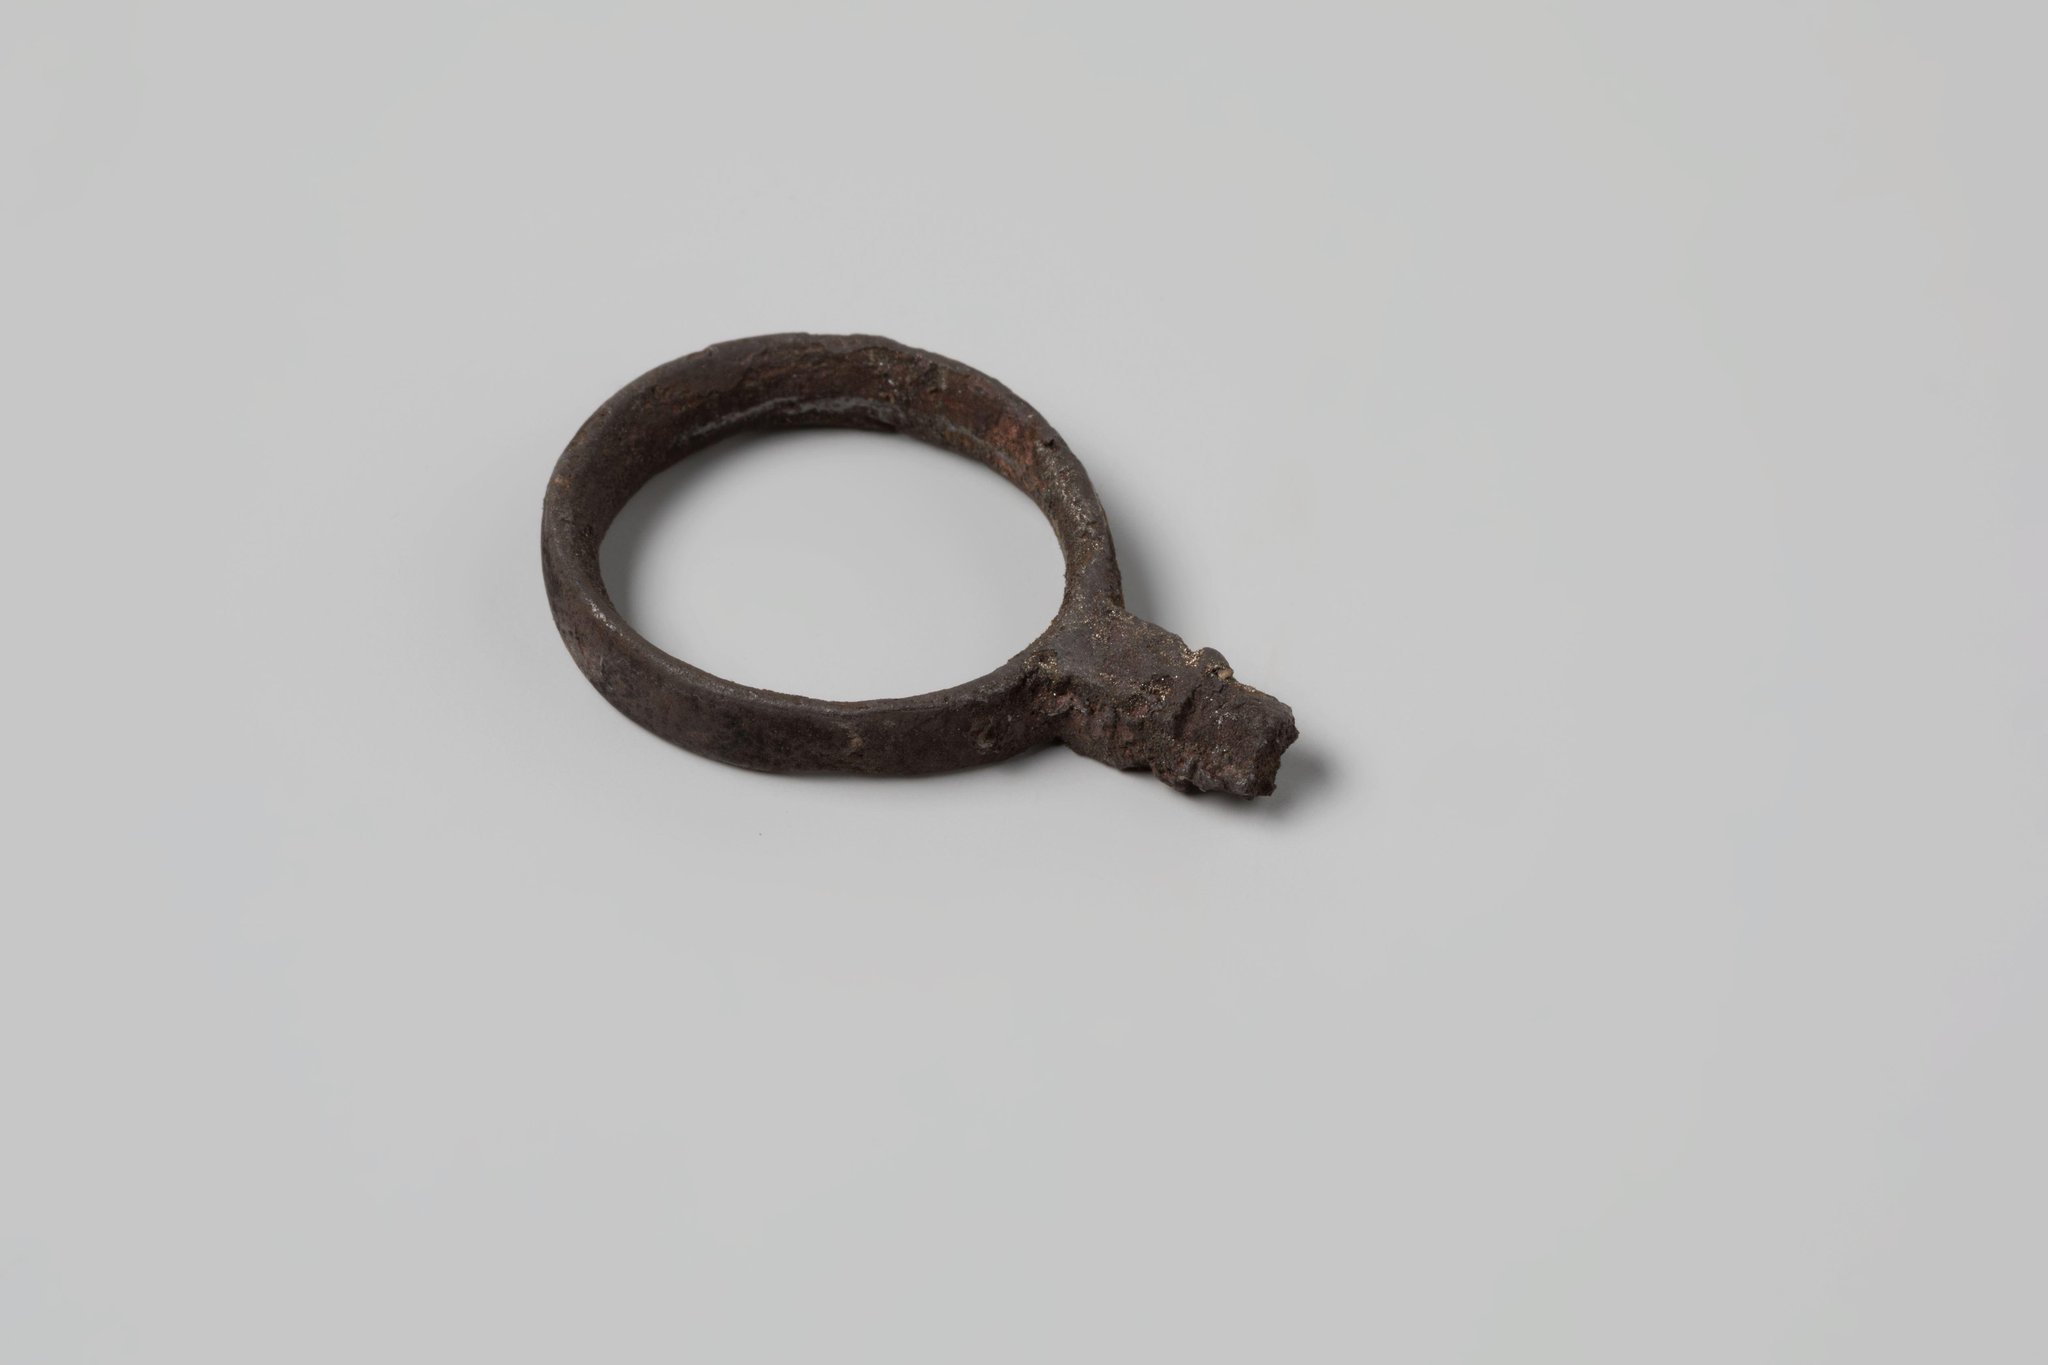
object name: pin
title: Speld uit het wrak van de Oost-Indiëvaarder Hollandia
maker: Anonymous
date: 1700-1743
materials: copper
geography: netherlands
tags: verenigde oostindische compagnie, hollandia (schip), annet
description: Tools and instruments, sewing and sailmaking, pin; fragm, bow, id. NG 1980-27H3265.